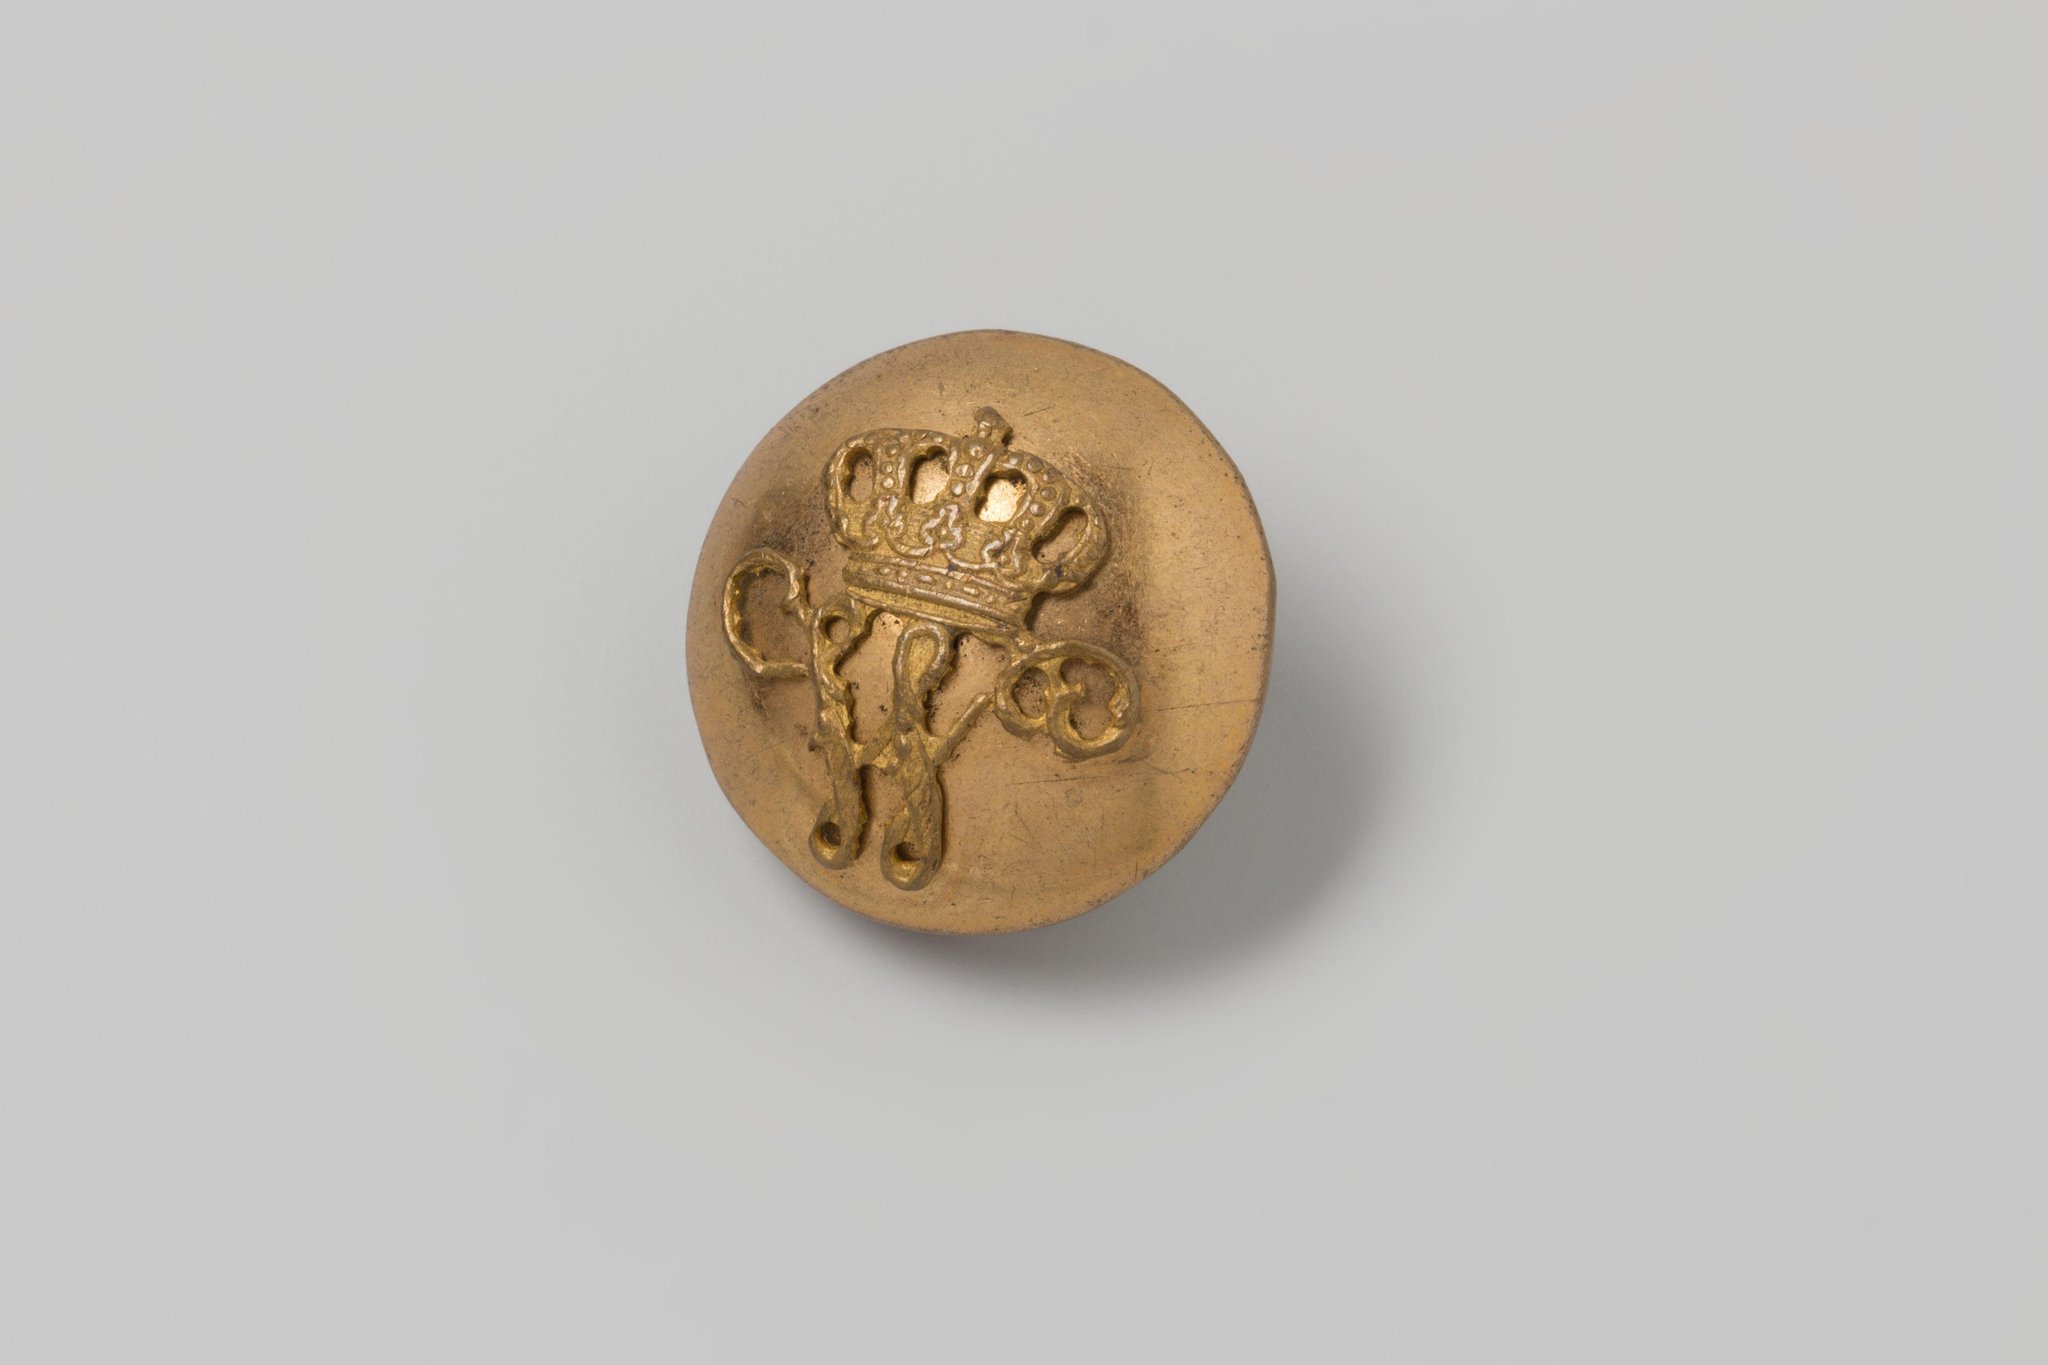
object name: clothing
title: Koperen knoop, glad en bol model, met daarop bevestigd een W onder een kroon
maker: Anonymous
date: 1880-1948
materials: copper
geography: utrecht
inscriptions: mark: ‘PARREE & ZONEN UTRECHT’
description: Koperen knoop, glad en bol model, met daarop bevestigd een W onder een kroon. Aan de achterzijde een oog.